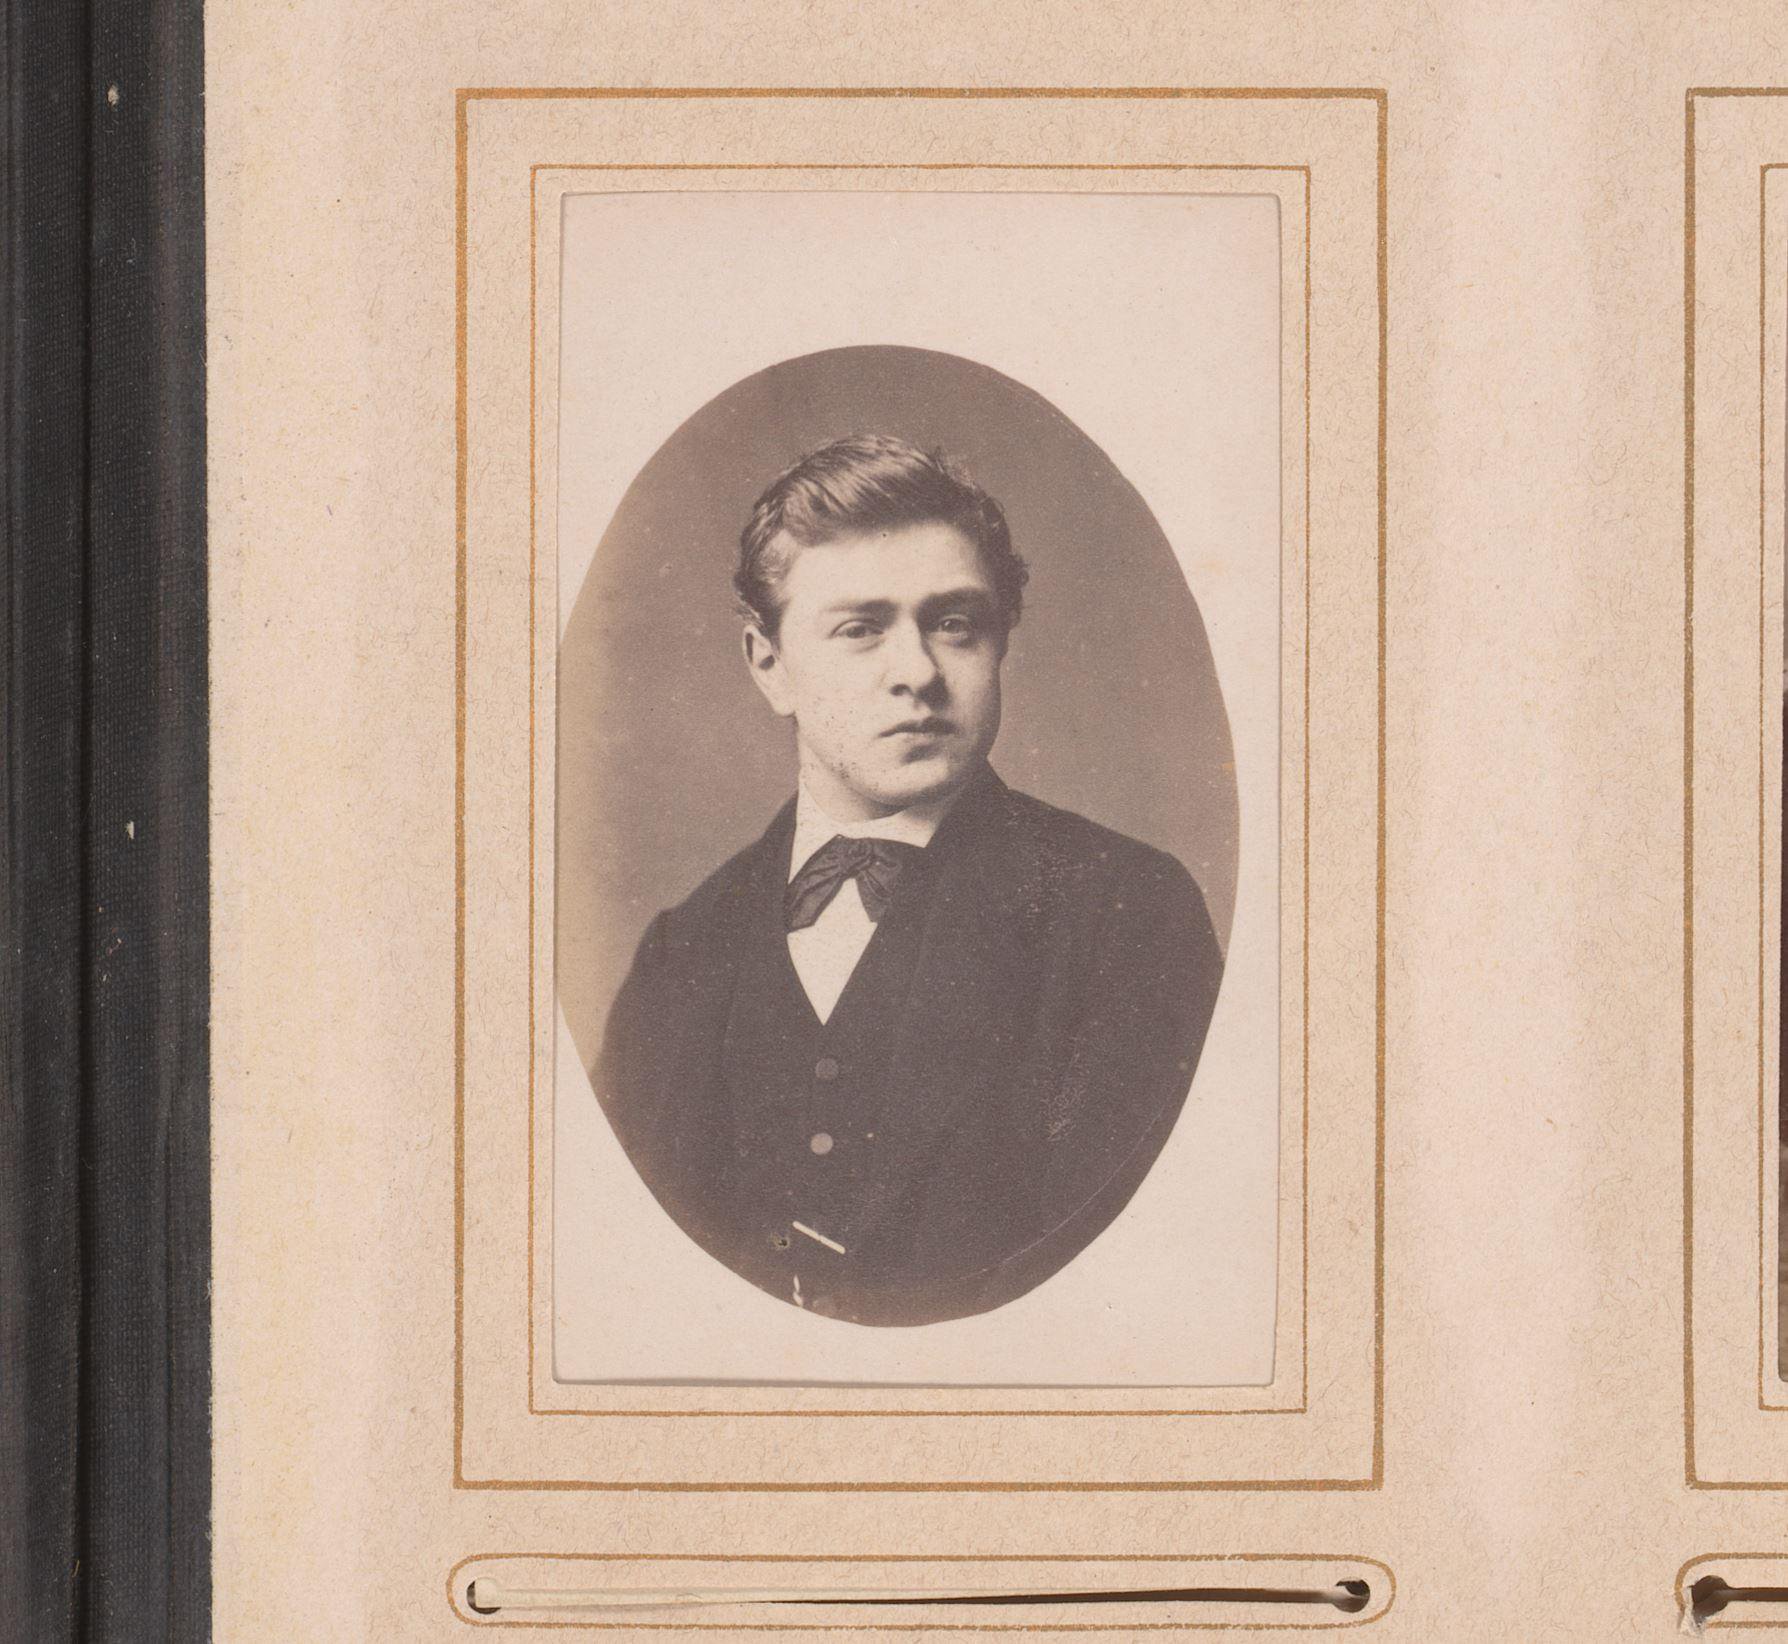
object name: album leaf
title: Portret van een jongeman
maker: Anonymous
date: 1870-1900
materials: cardboard, photographic support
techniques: albumen print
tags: historical persons, youth, adolescent